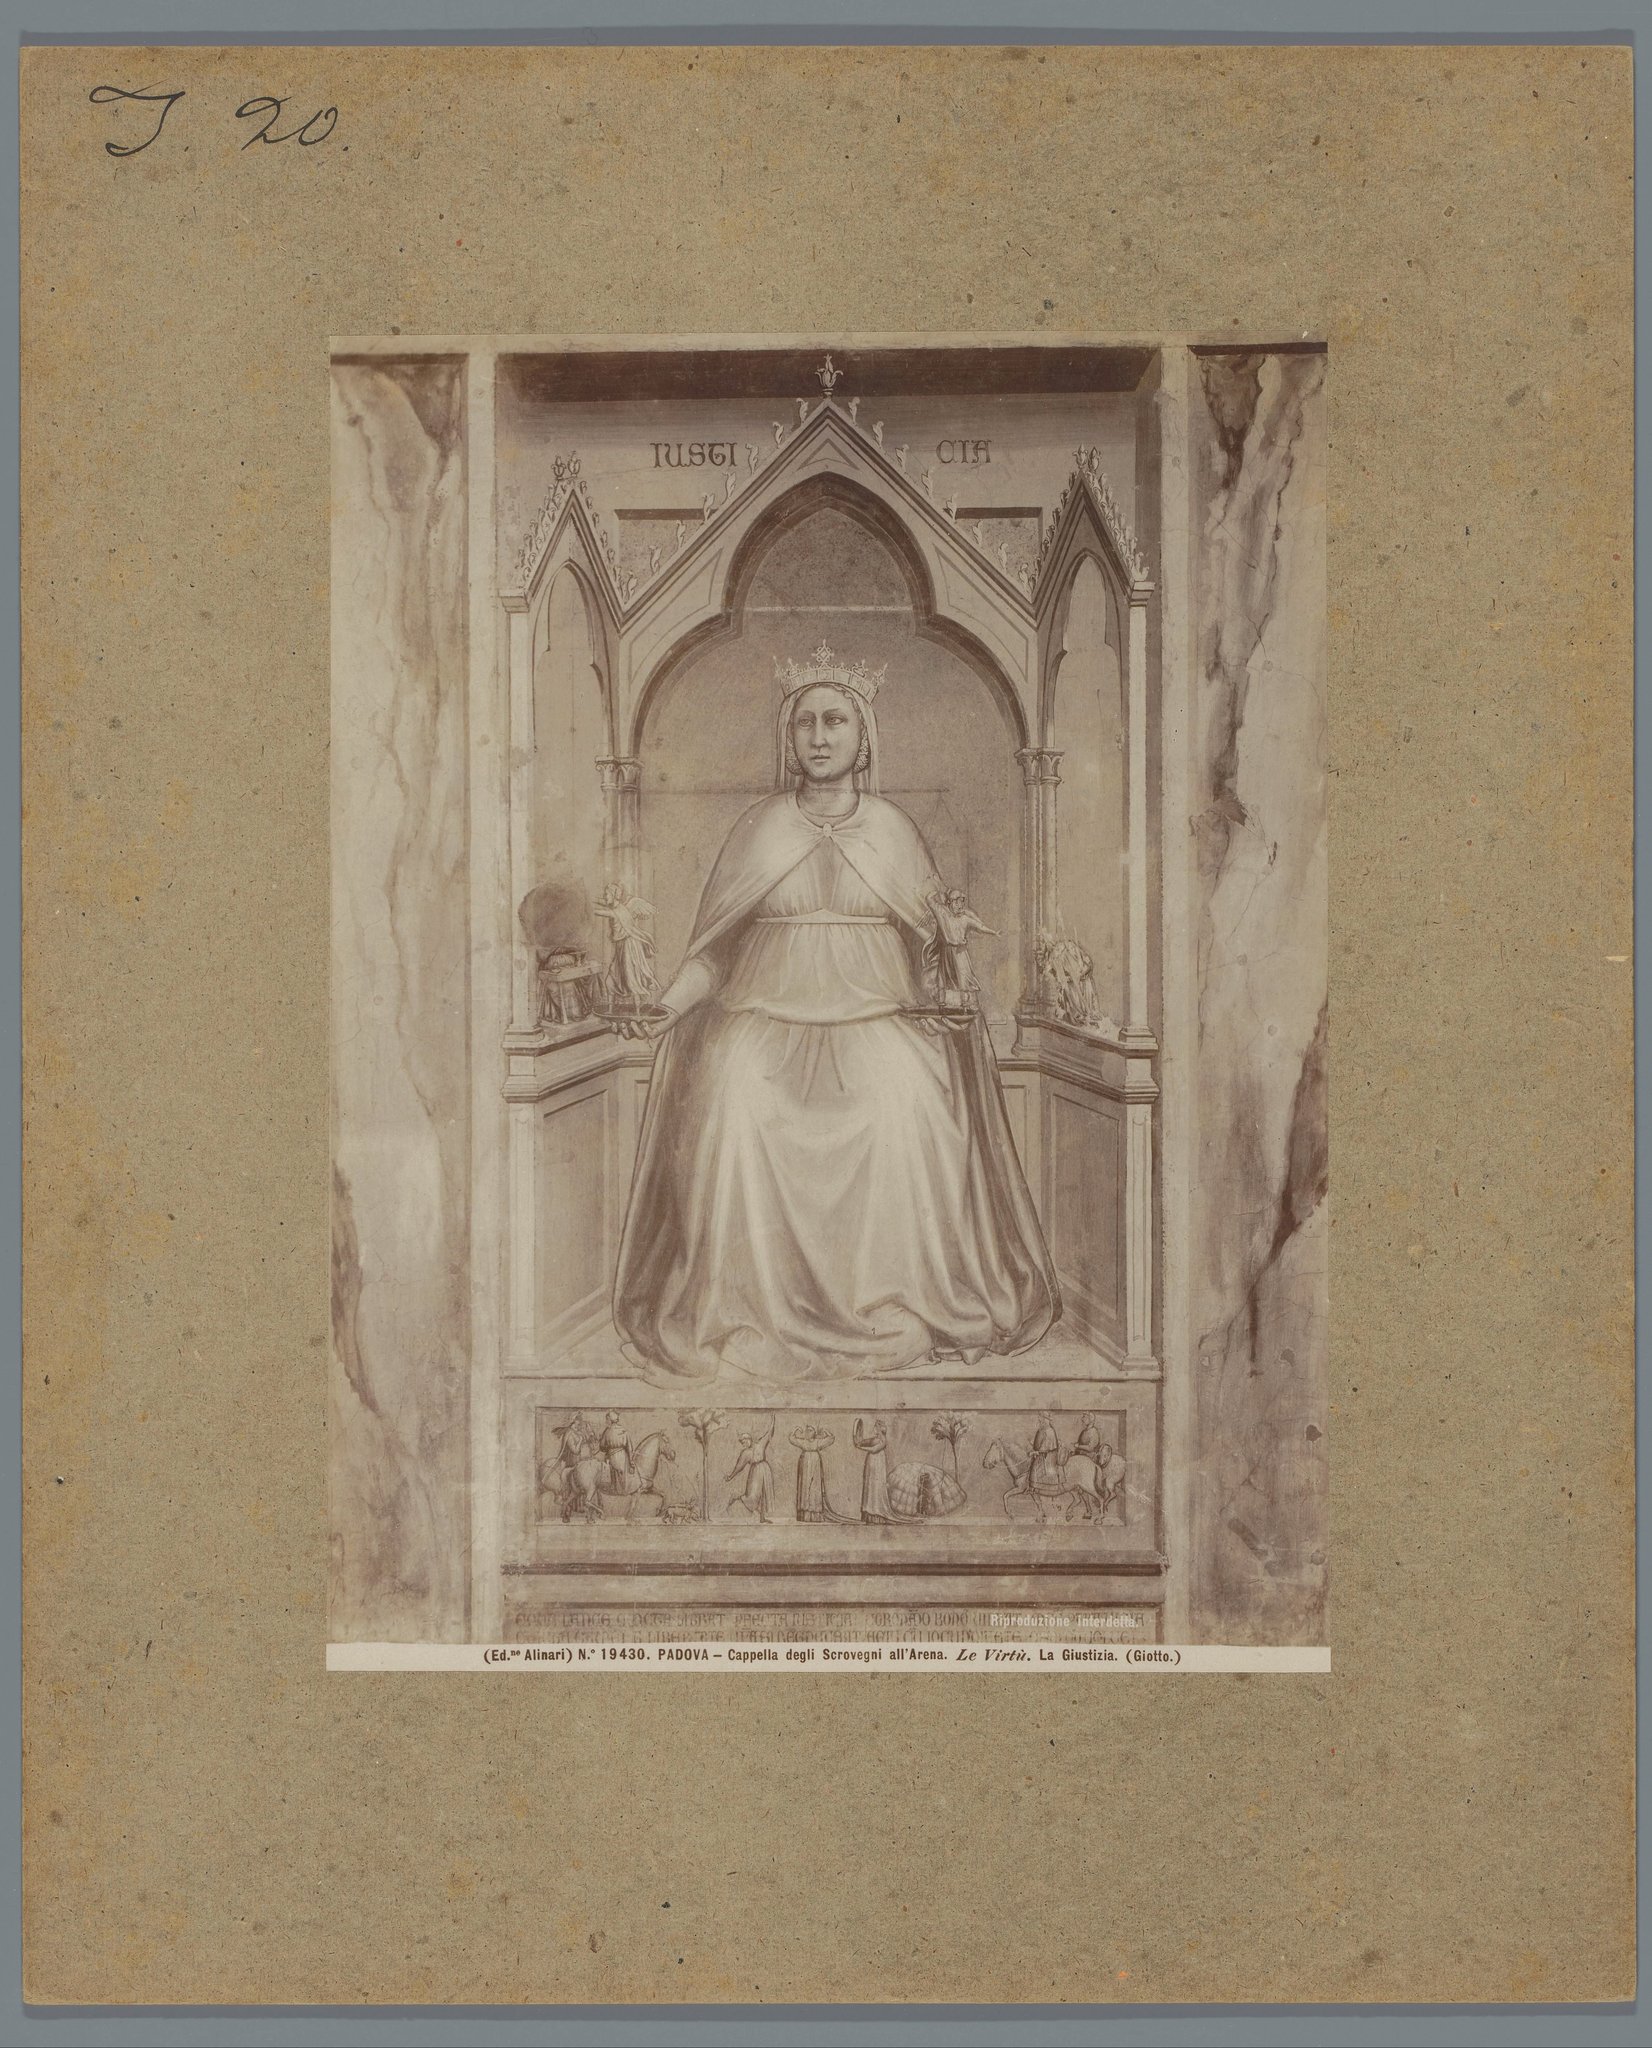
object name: photograph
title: PADOVA - Cappella degli Scrovegni all'Arena. Le Virtù. La Giustizia.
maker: giotto de bondone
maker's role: painter, sculptor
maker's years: 1266-1337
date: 1875-1900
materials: cardboard, photographic support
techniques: albumen print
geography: scrovegnikapel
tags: justice, 'justitia'; 'giustitia divina' (ripa) ~ one of the four cardinal virtues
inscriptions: collector's mark: Lugt 3937, number: ‘No. 19430.’